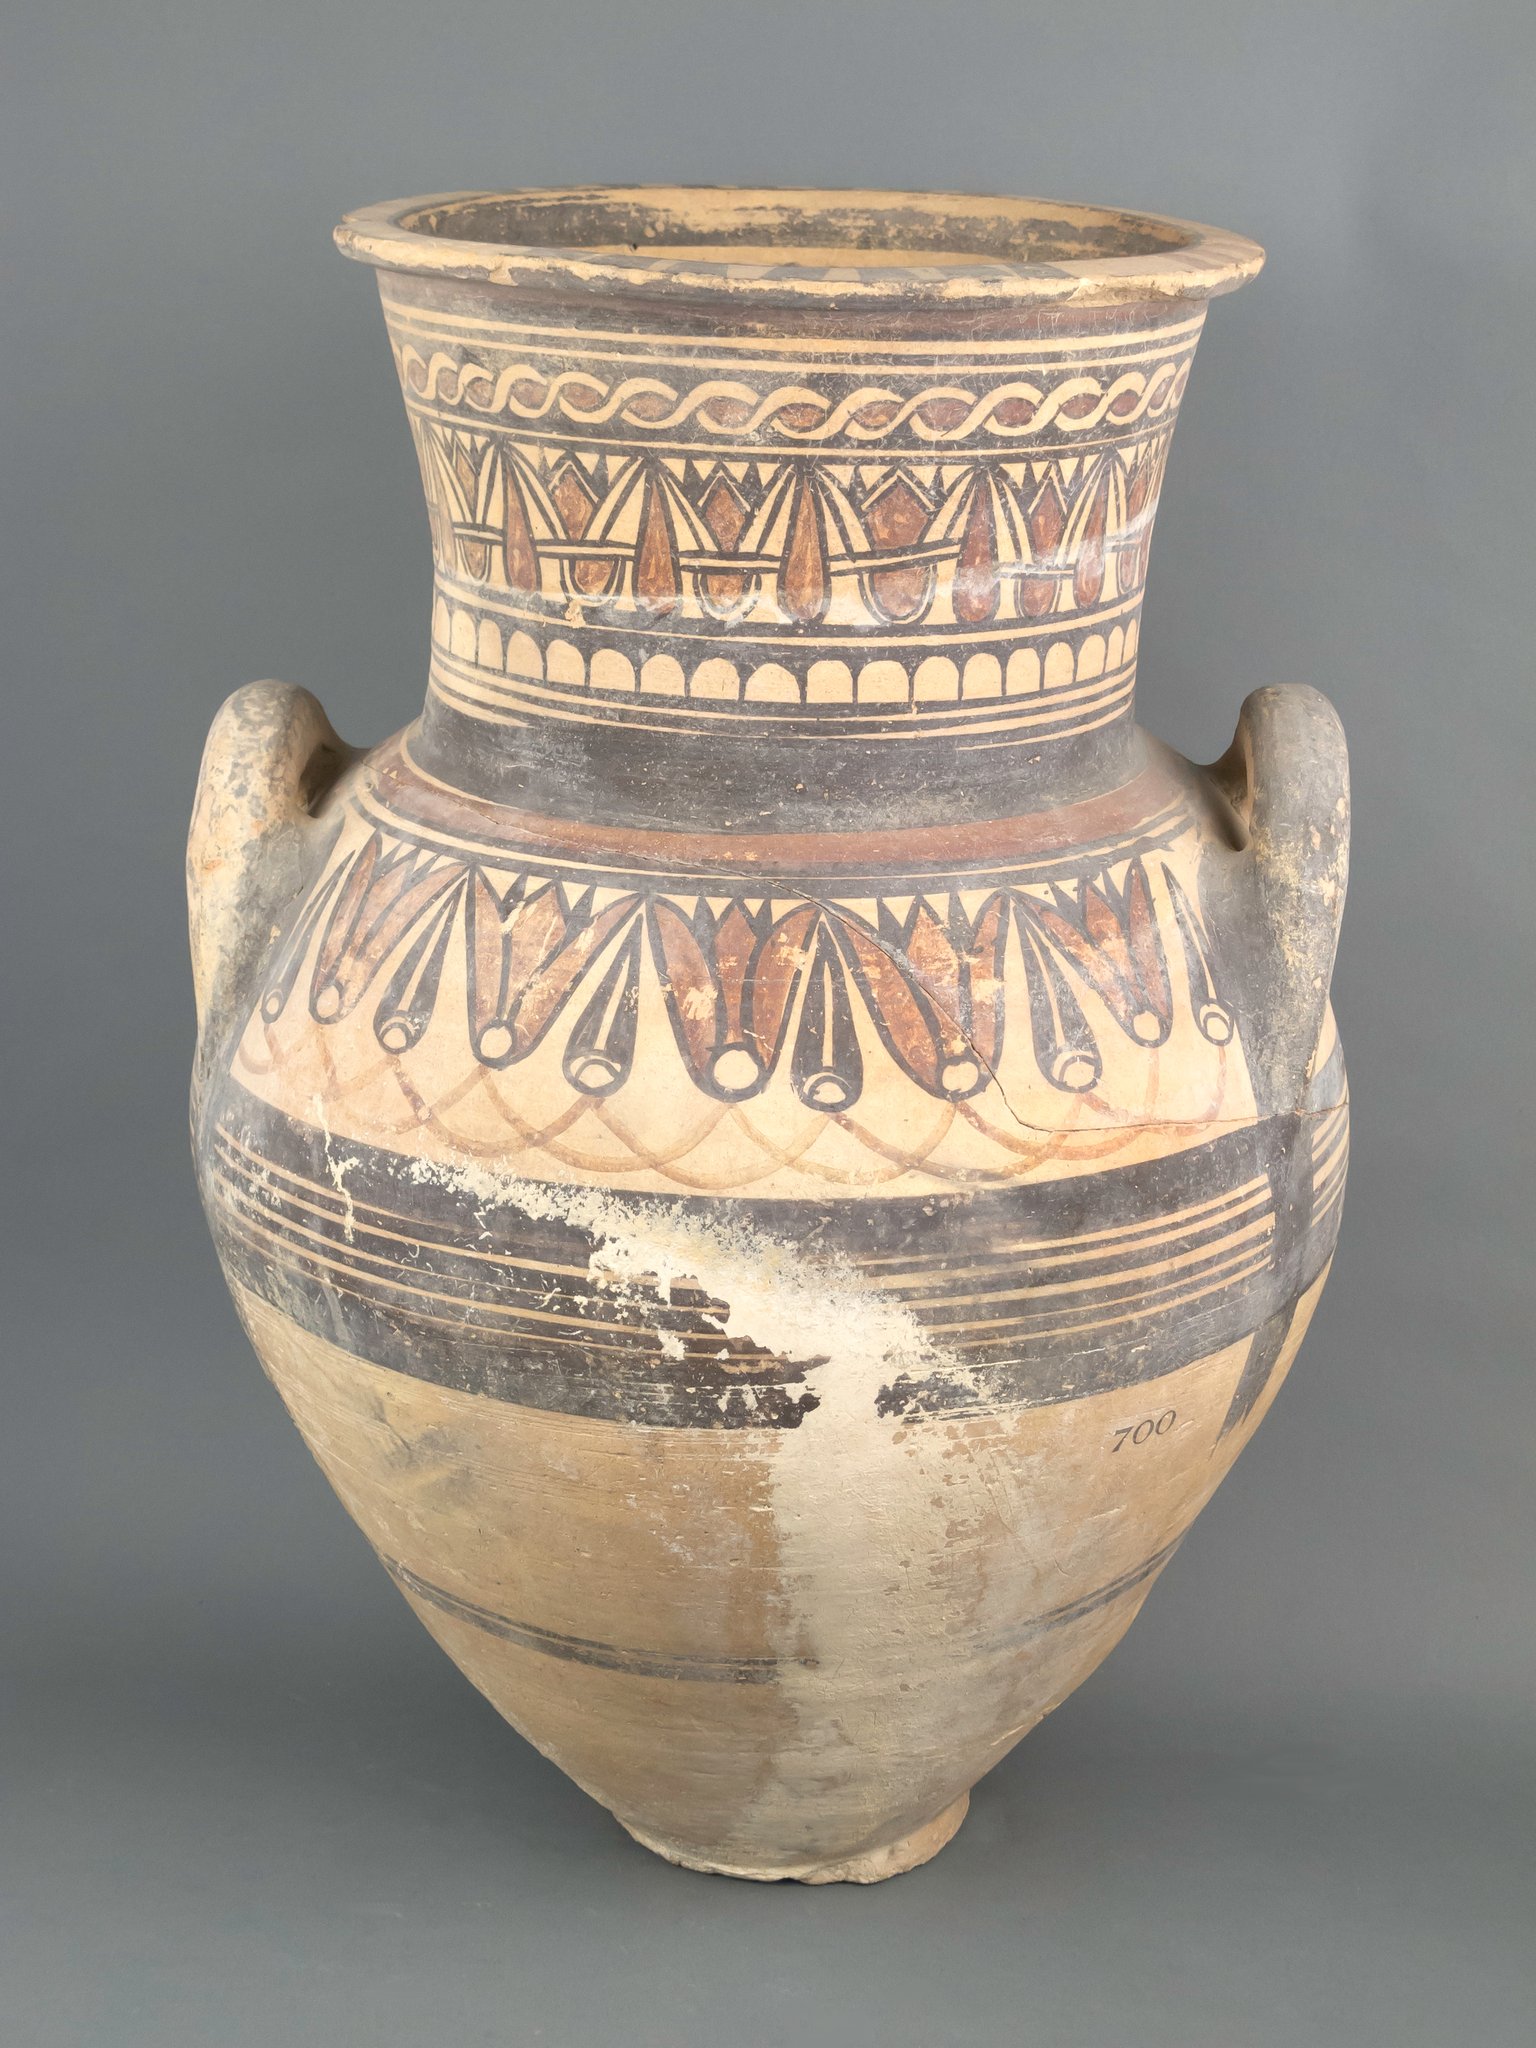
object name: amphora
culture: cypriot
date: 750-600 BCE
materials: terracotta